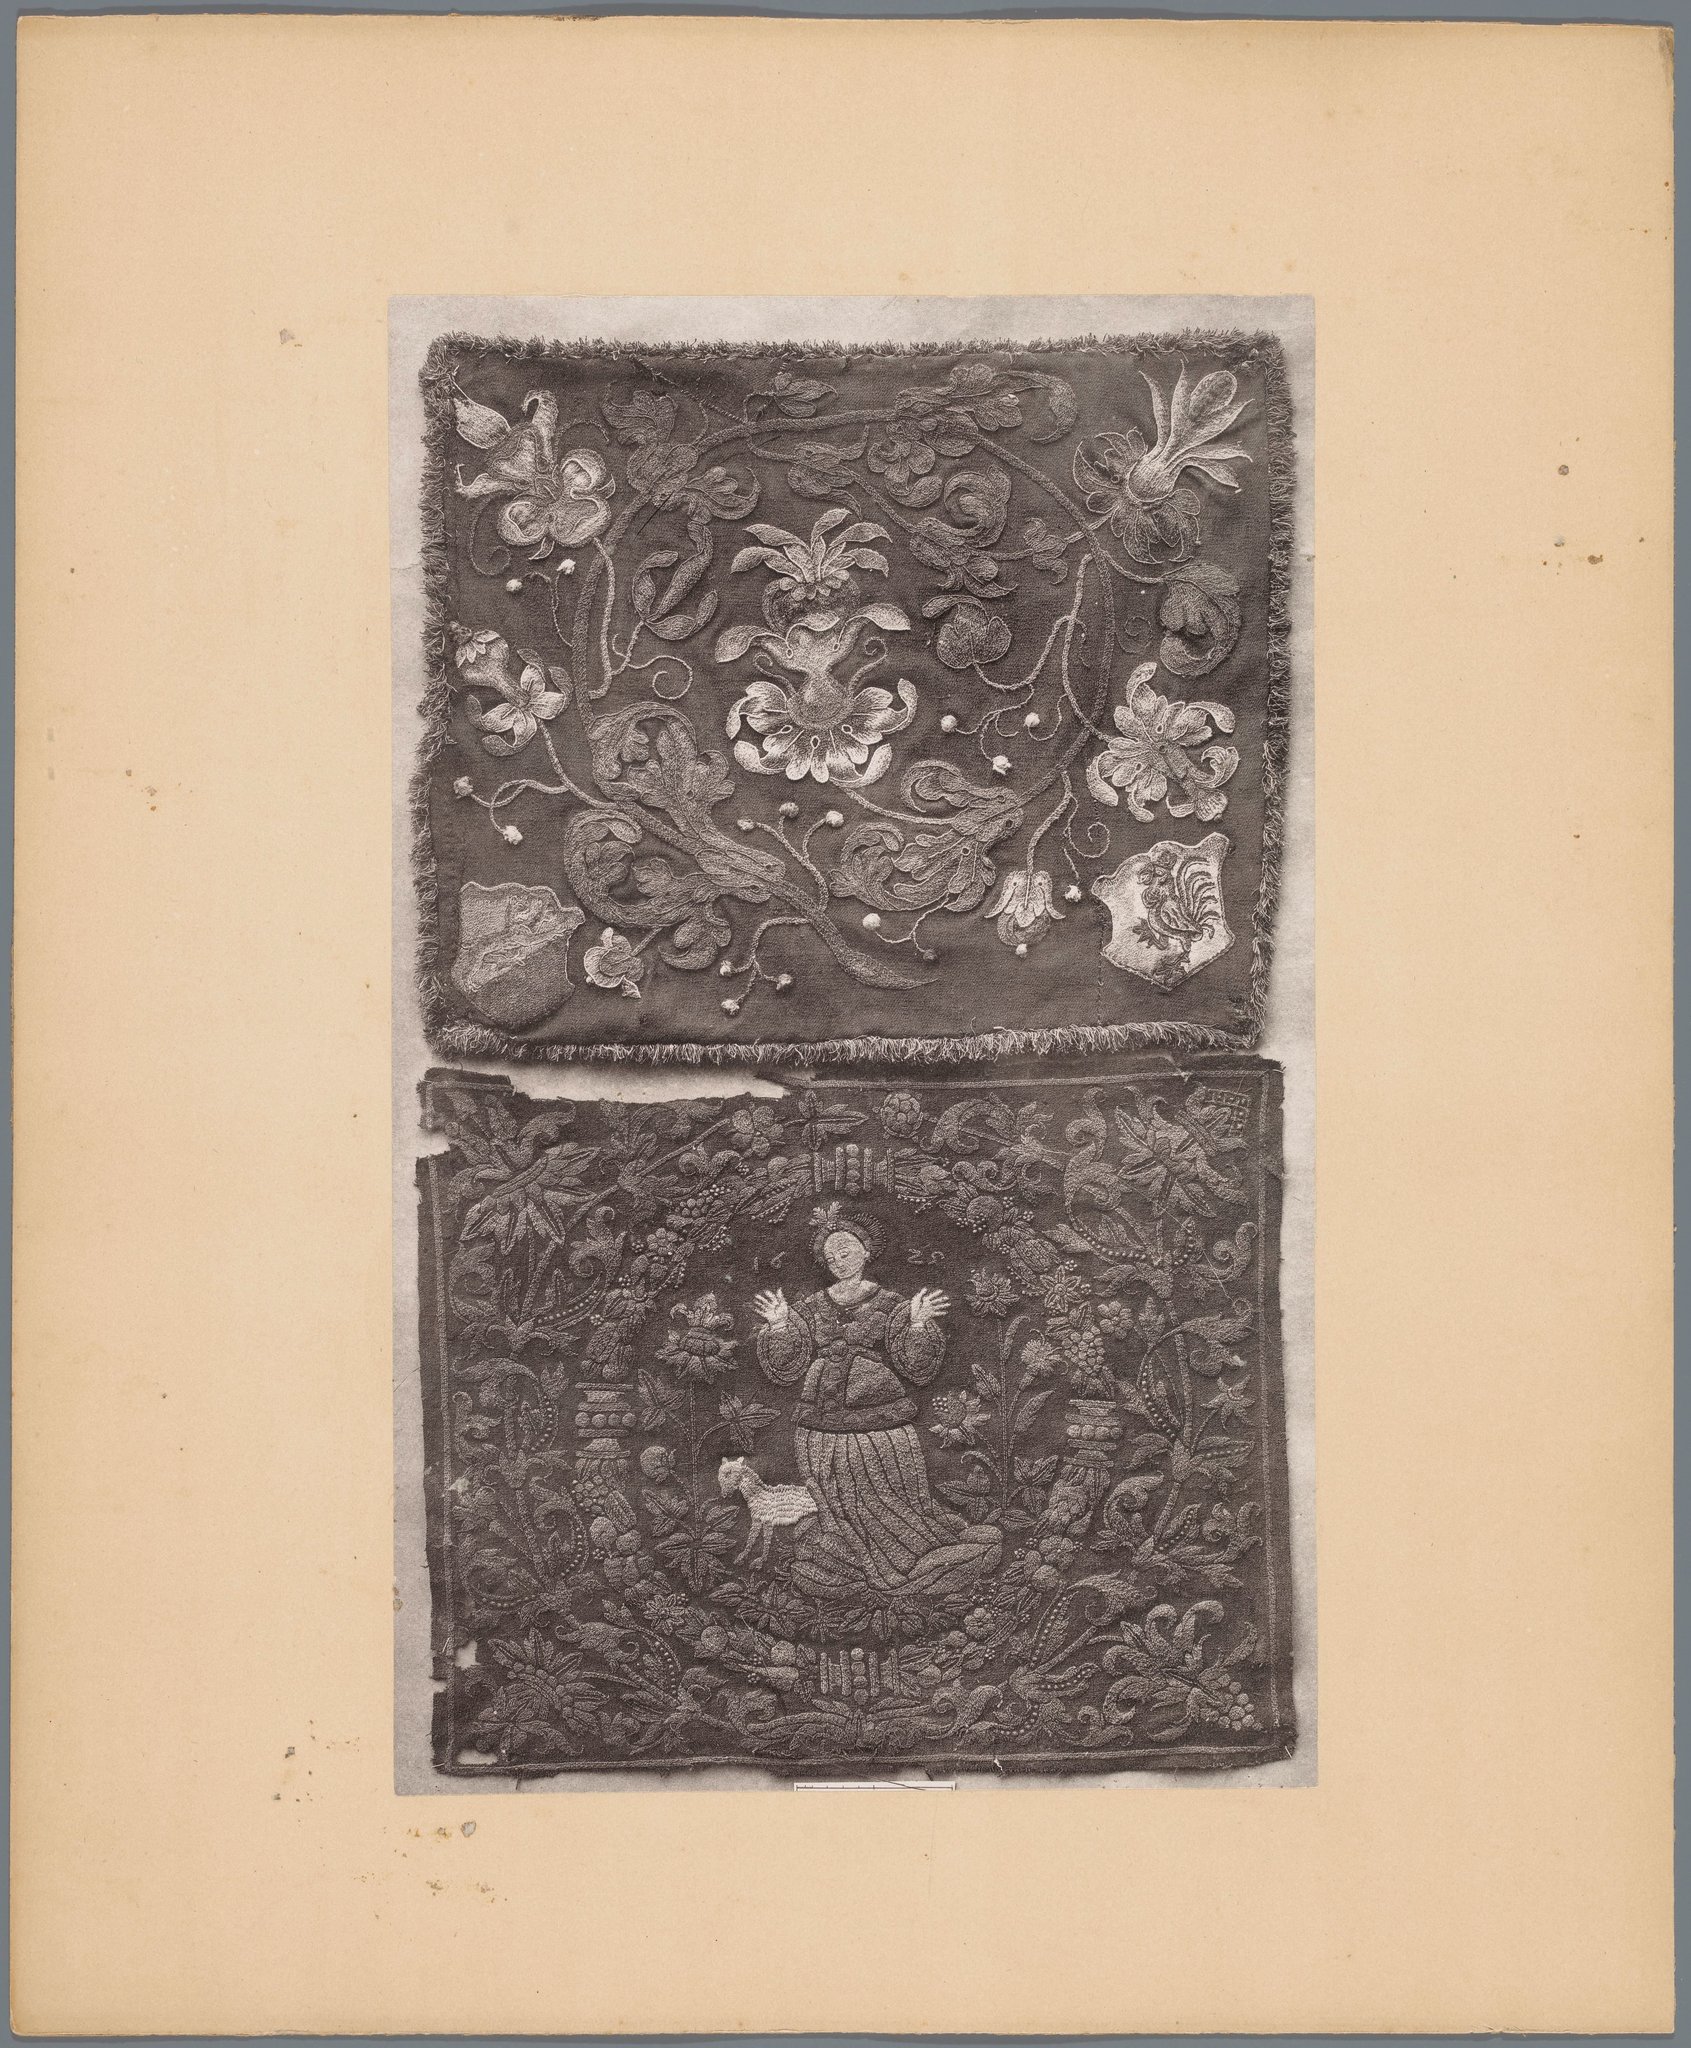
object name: photograph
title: Twee lappen textiel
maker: Anonymous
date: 1875-1900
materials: cardboard, paper, ink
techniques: photograph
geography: europe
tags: coat of arms (as symbol of the state, etc.), lamb, textile fabric, cloth, europe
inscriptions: collector's mark: Lugt 3937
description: Boven: gedecoreerd met bloemmotieven en wapenschilden, onder: gedecoreerd met een vrouw en een lam.